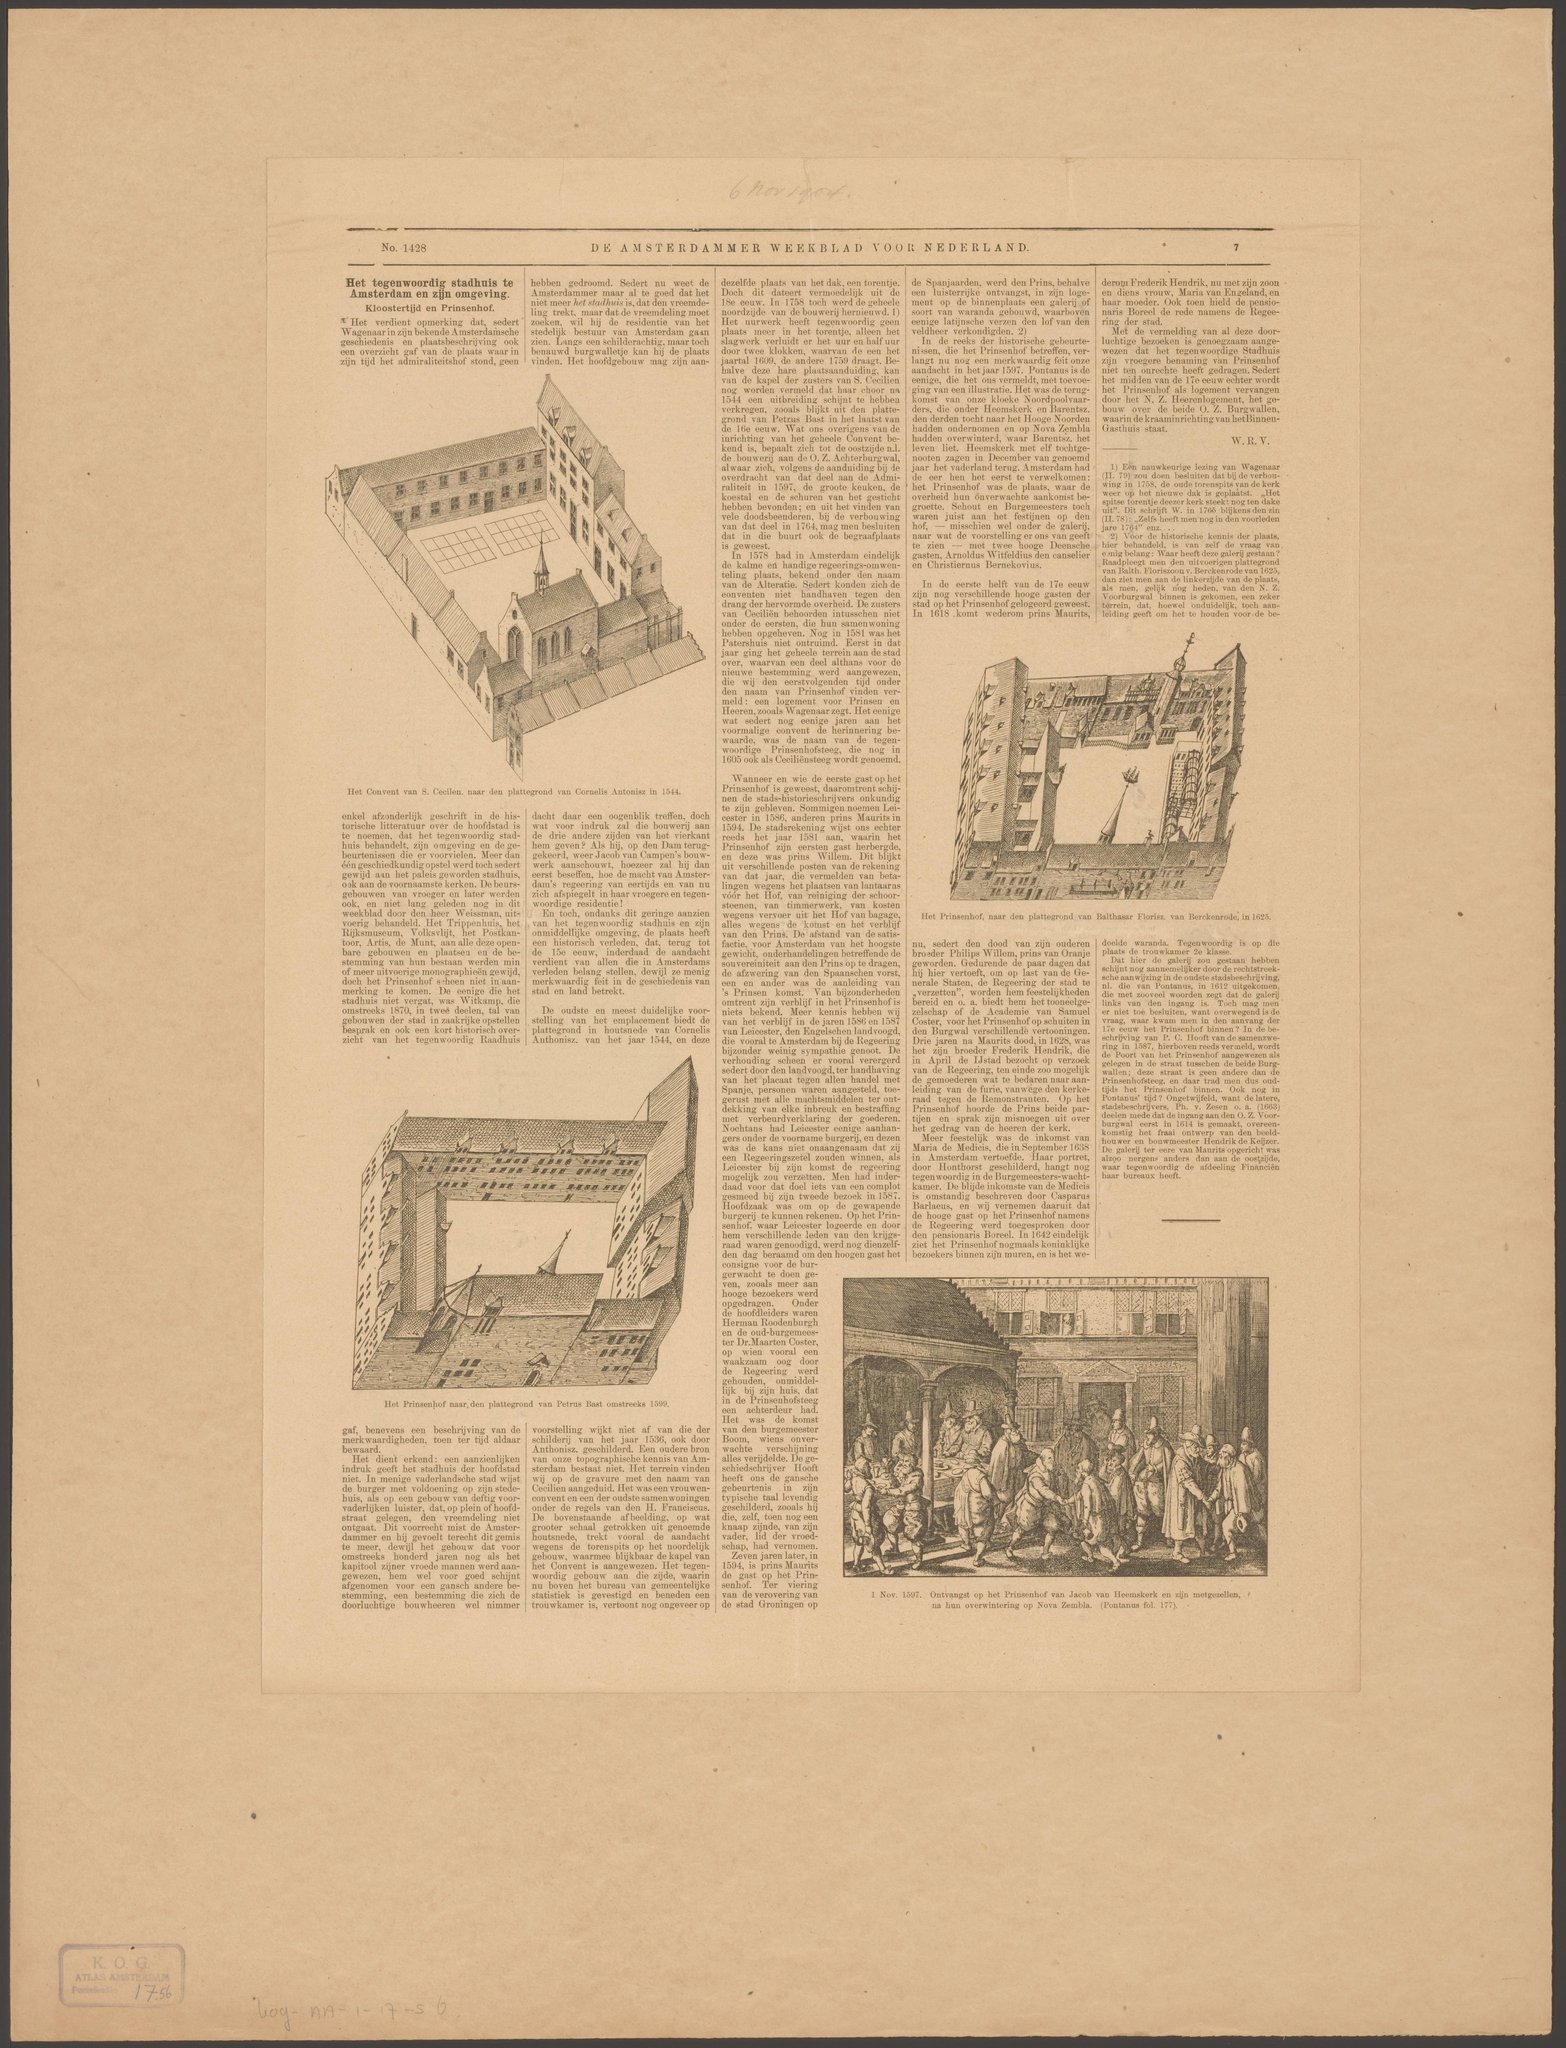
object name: photomechanical print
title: Gezicht op de omgeving rondom het stadhuis aan het Prinsenhof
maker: Anonymous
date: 1904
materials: paper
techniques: letterpress printing, line block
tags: city-view in general; 'veduta', townhall, plan ~ architecture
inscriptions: collector's mark: ‘17.56’ Lugt 1641b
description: Onderwerpsrubriek binnen de Atlas Amsterdam: Nieuwe Stadhuis, van binnen: Vaartuigen en Gebouwen ten dienste der Stedelijke Regeering en Administratie; Stadhuis (Prinsenhof).